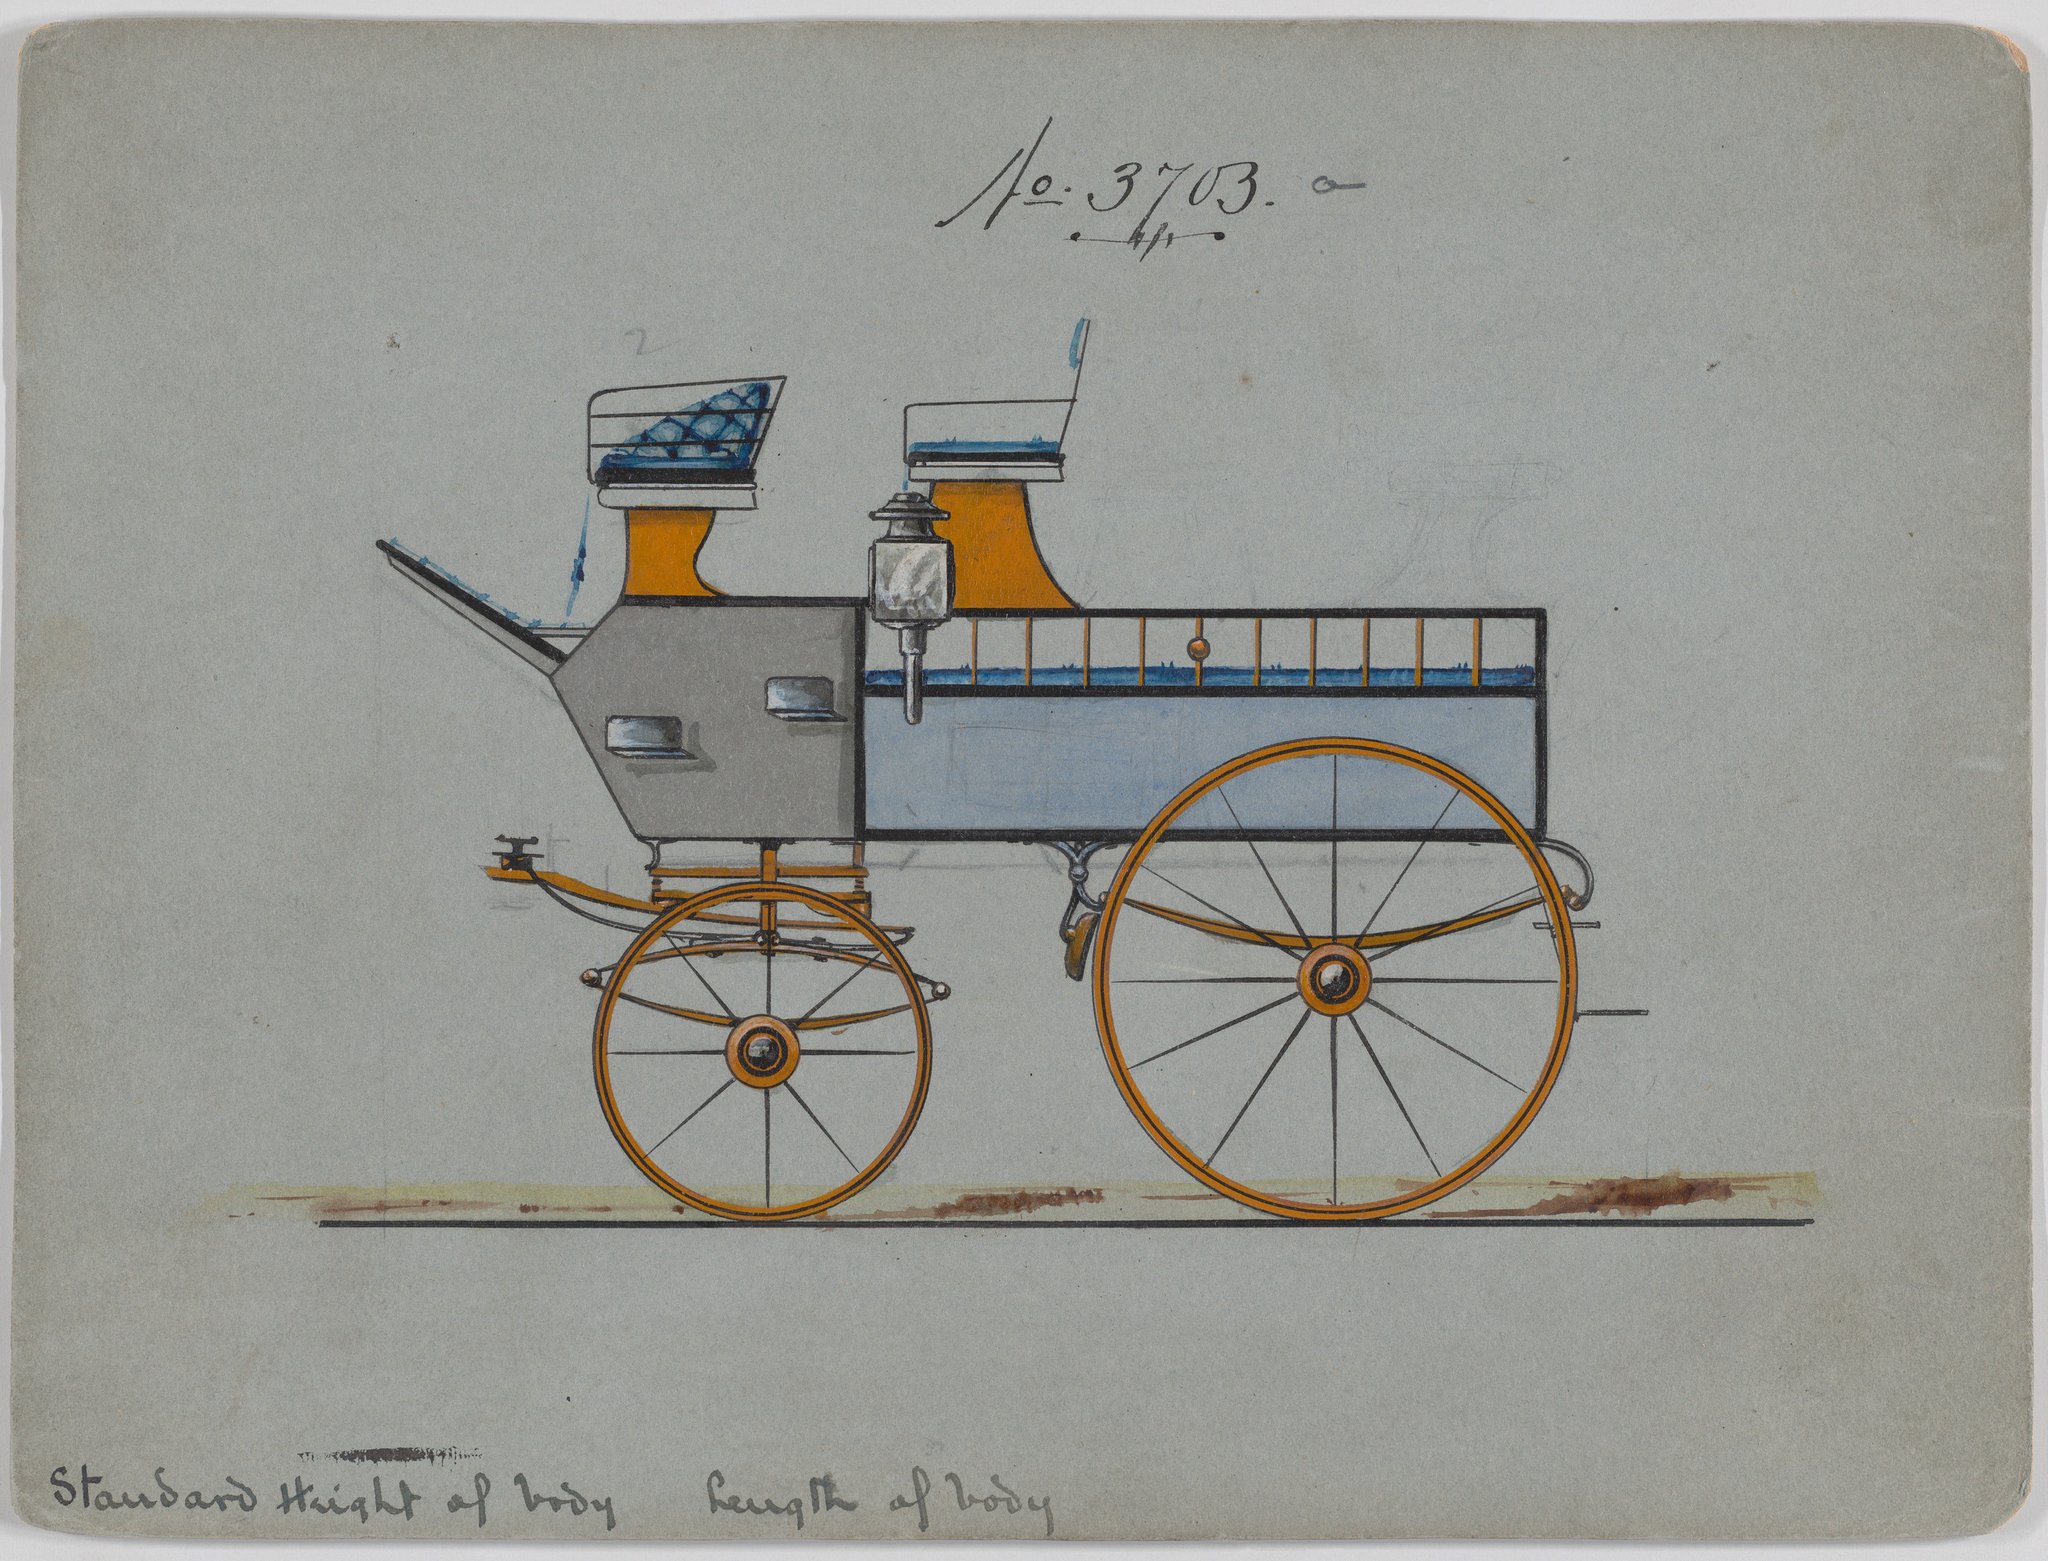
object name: drawing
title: Wagonette Break #3703a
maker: brewster & co.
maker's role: manufacturer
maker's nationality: american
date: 1881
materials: gouache, graphite, gum arabic, ink, watercolor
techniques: pen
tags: carriages